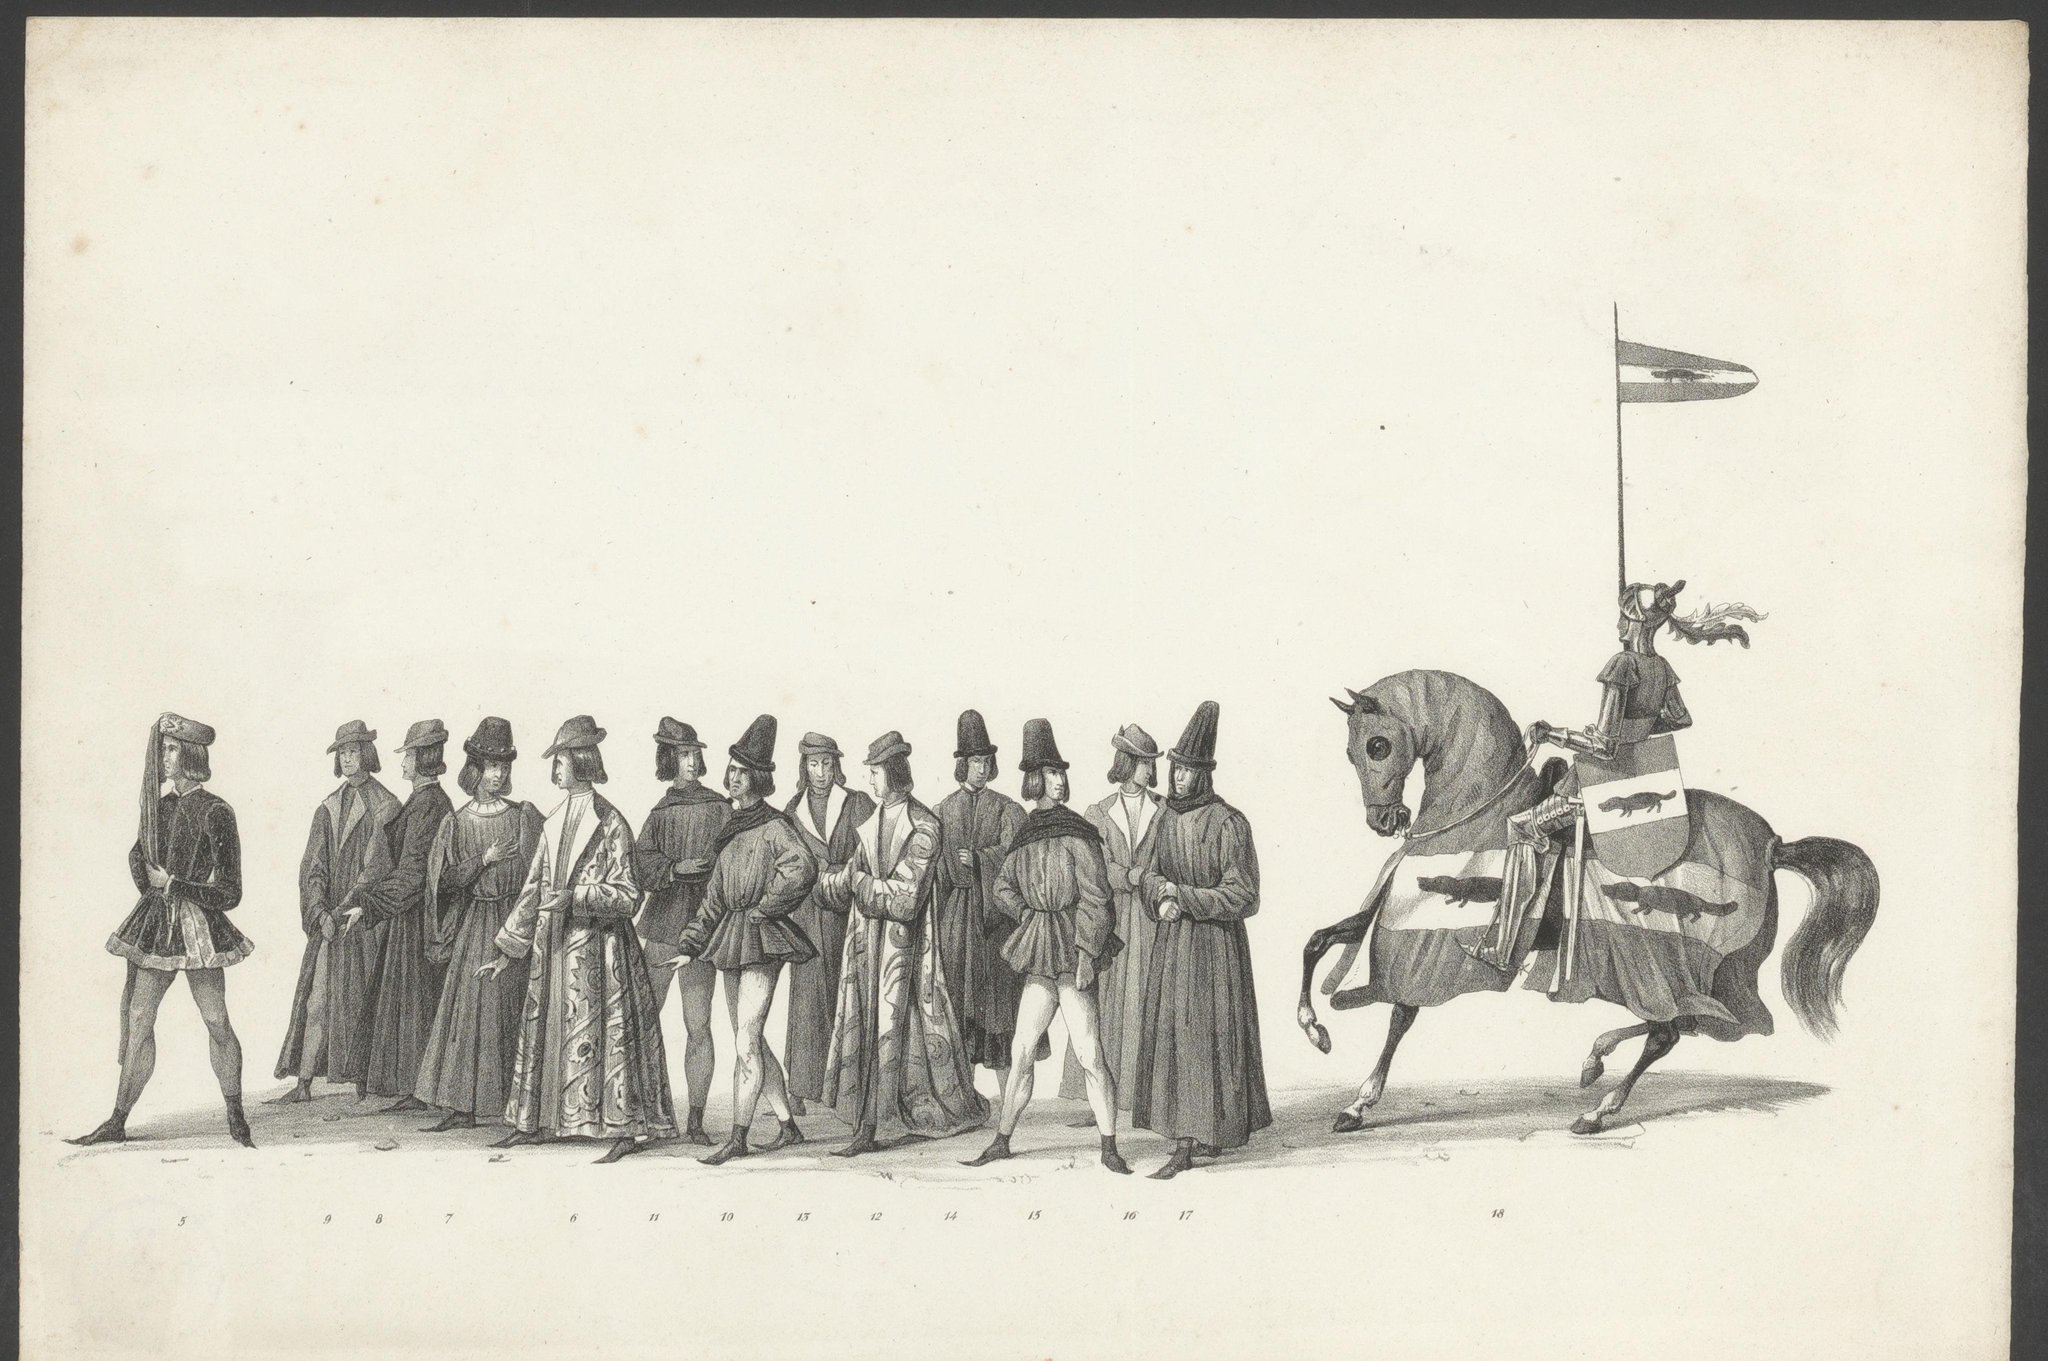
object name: print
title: De intogt van Hertog Jan van Beijeren binnen Leyden. Op den 18den Augustus 1420 in Maskerade voorgesteld door H.H. Studenten der Leydsche Hoogeschool, Op den 8sten Februarij 1840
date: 1840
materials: paper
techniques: lithograph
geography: leiden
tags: jan van beieren, students' pageant, triumphal entry and public reception, pageant, 'entrée solennelle', 'joyeuse entrée'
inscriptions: collector's mark: Lugt 1641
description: Raadslieden en schepenen. Historische gekostumeerde optocht van de studenten van de Hogeschool van Leiden op 8 februari 1840. De optocht verbeeldt de intocht van hertog Jan van Beieren te Leiden op 18 augustus 1420. Onderaan genummerd: 5 t/m 18. Onderwerpsrubrieken binnen de Atlas Zeden en Gewoonten: Onderwijs en Wetenschappen, Studentenleven.